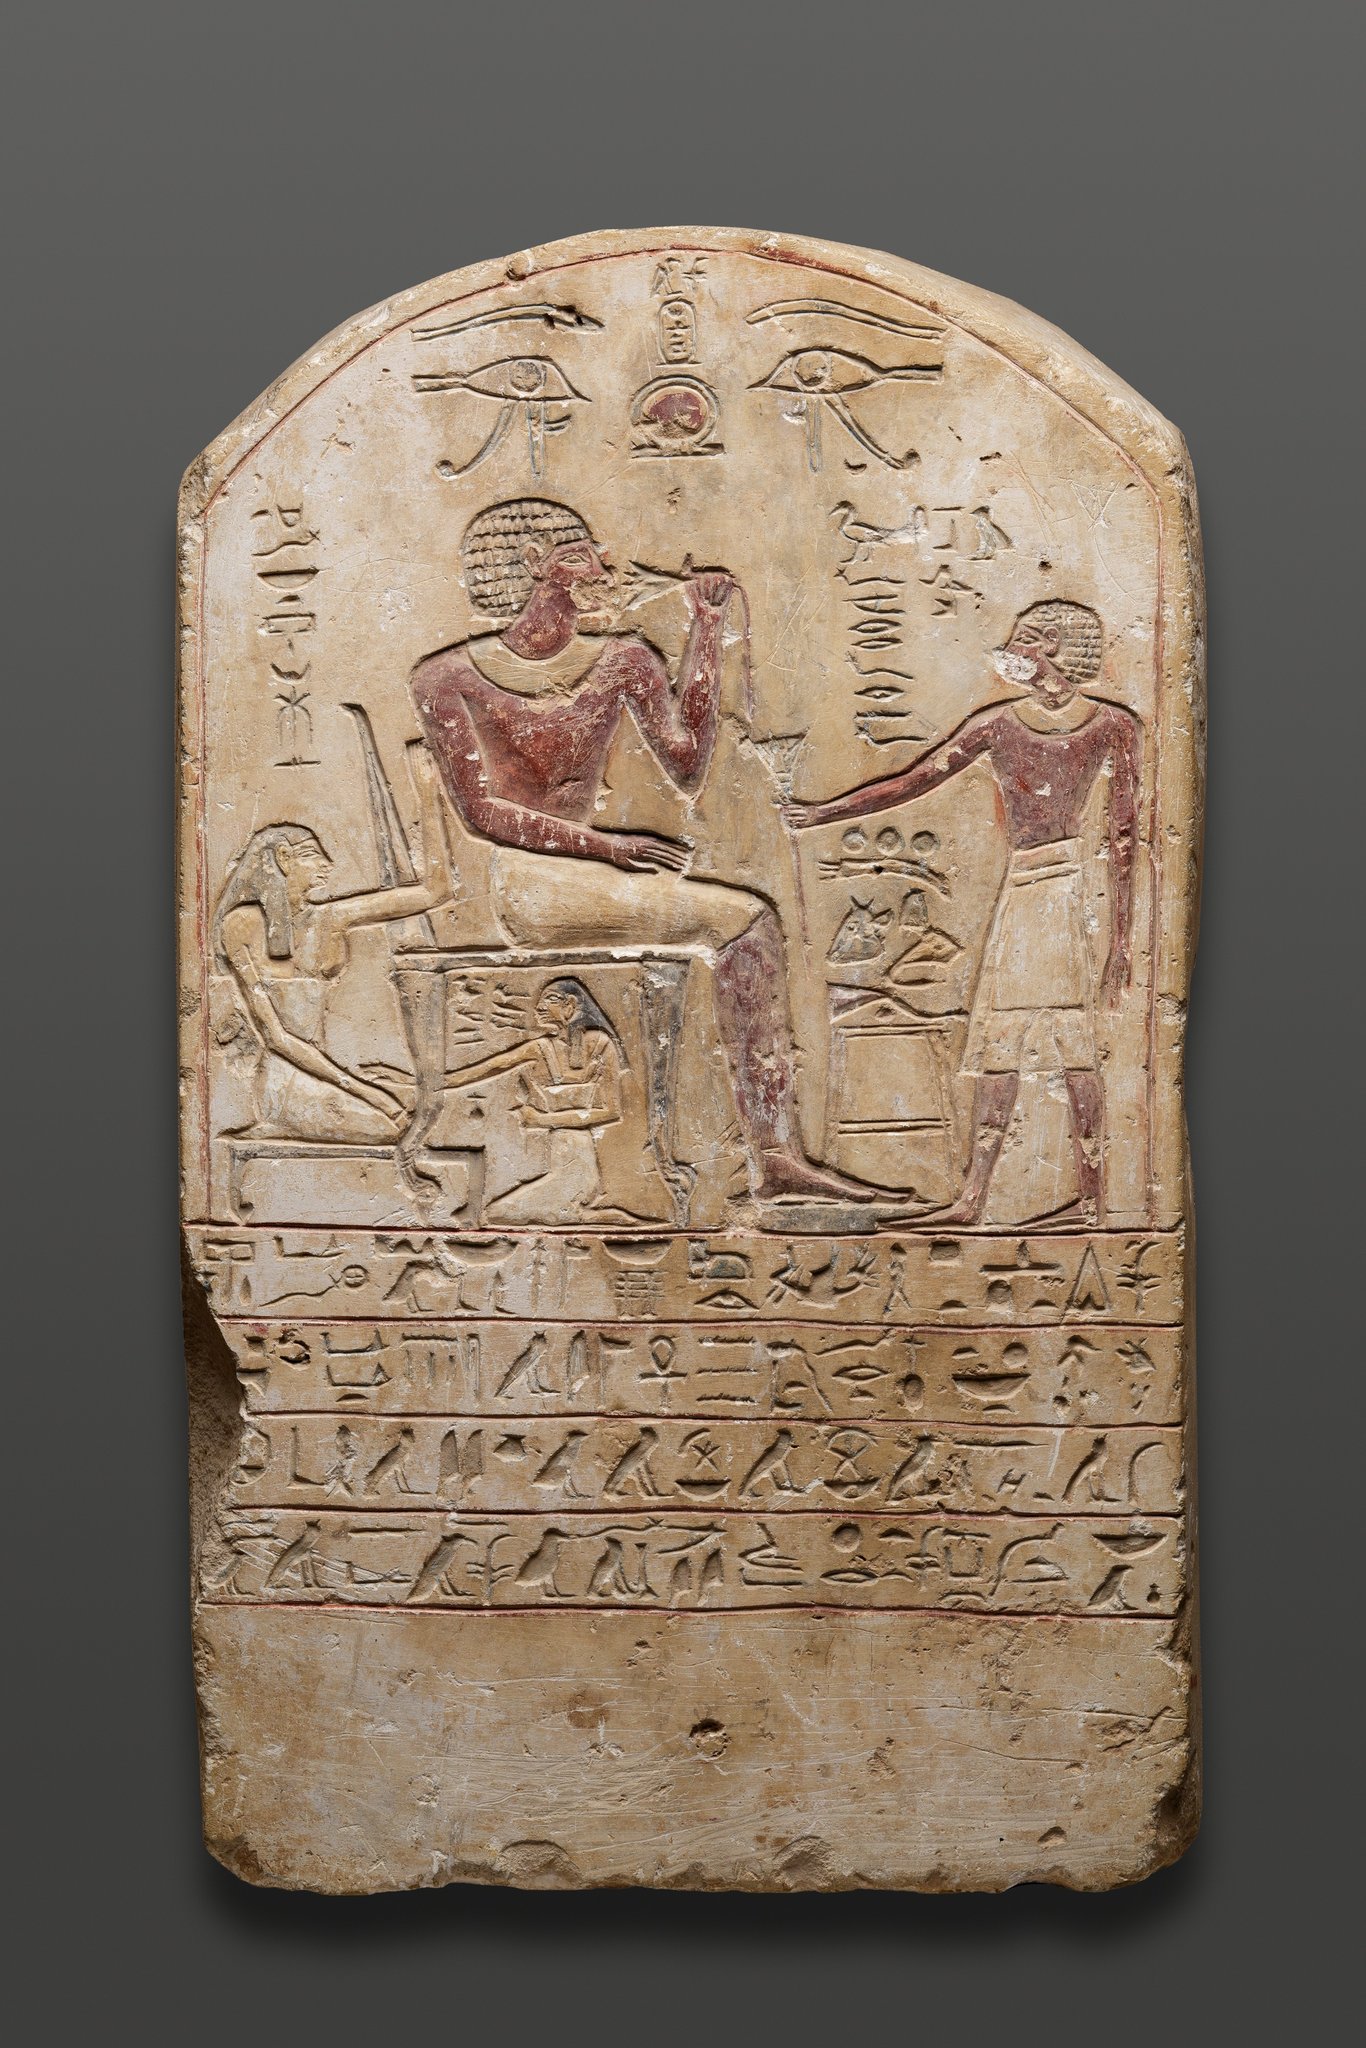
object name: stela, aamtju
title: Stela of Aamtju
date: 1550-1504 BCE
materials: limestone, paint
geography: egypt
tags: men,hieroglyphs